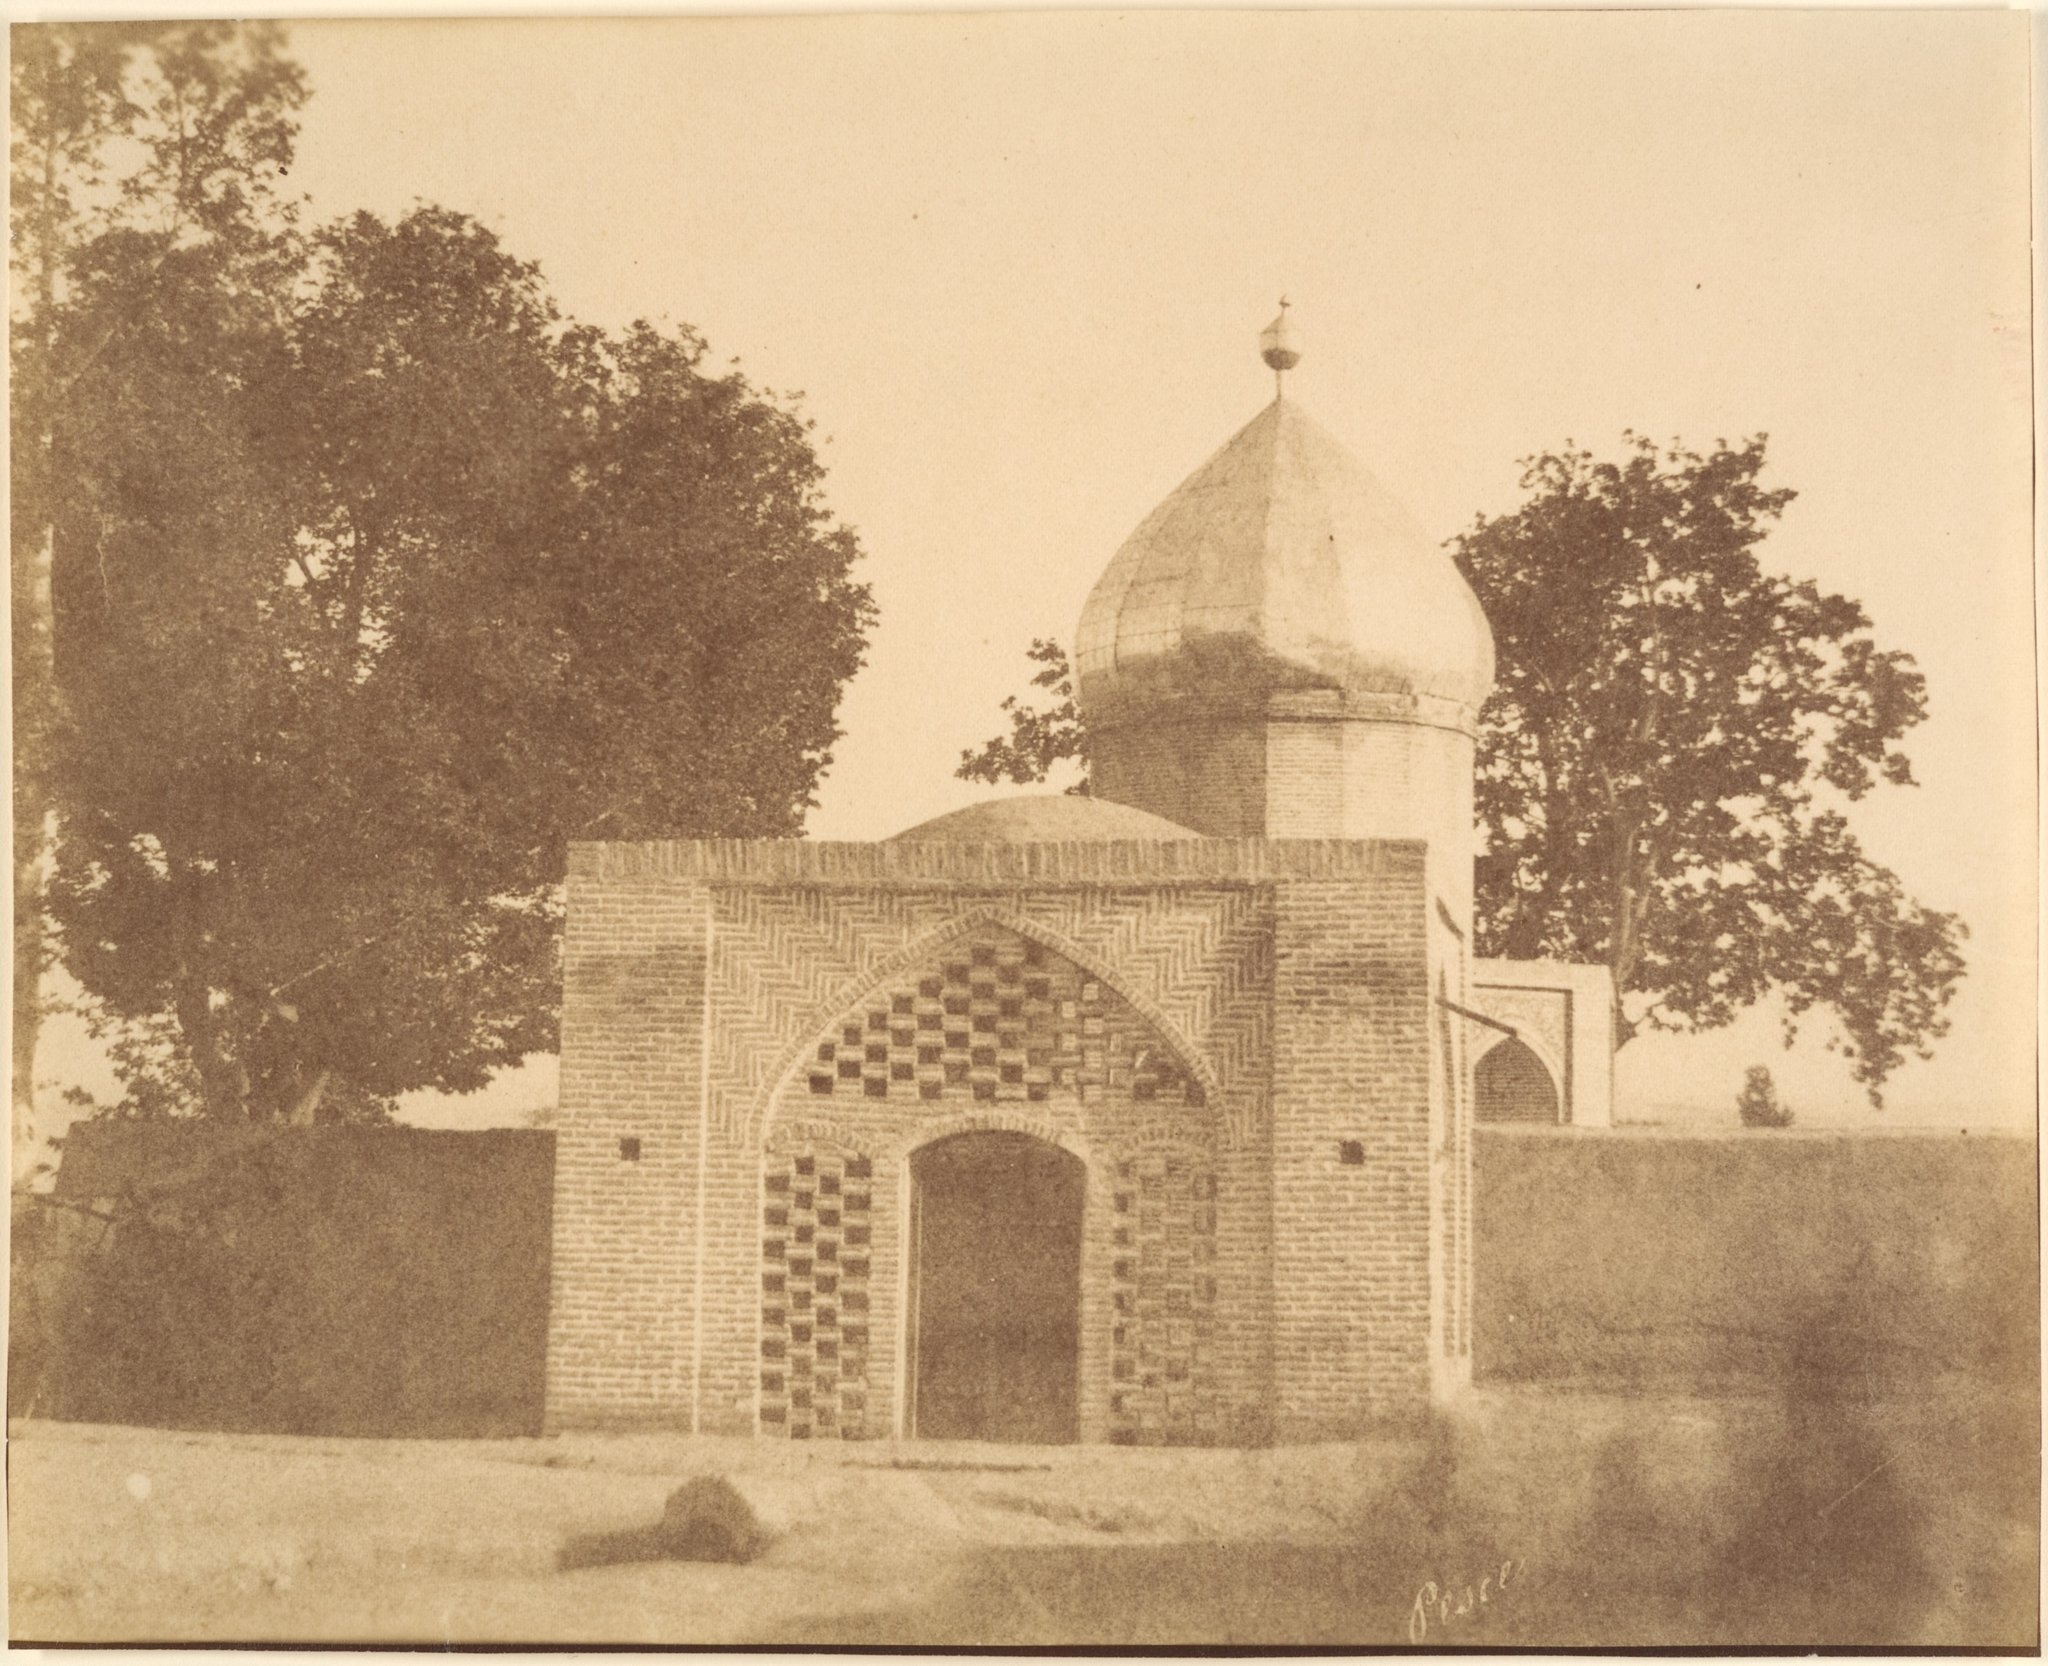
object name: photograph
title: [Tomb of Khan of Khiva, Uzbekistan]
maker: luigi pesce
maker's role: artist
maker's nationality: italian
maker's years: 1818-1891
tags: architecture,tombs